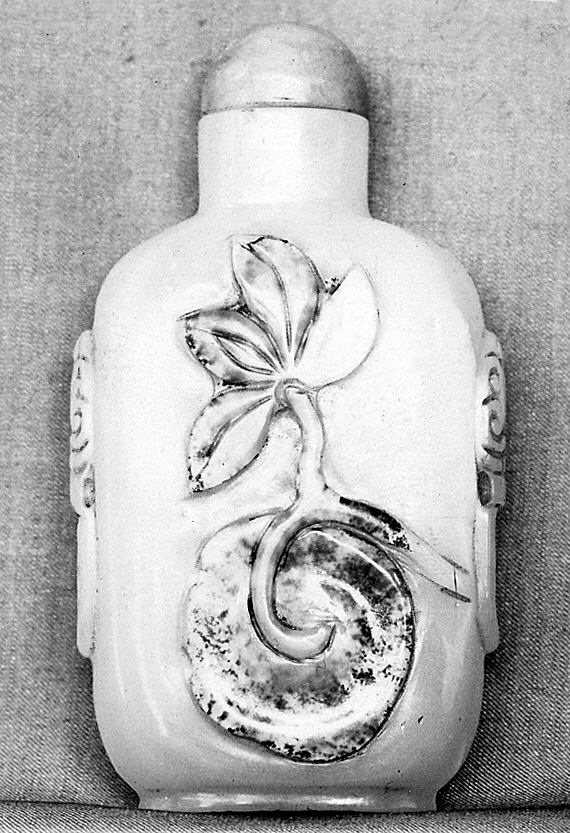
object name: snuff bottle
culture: chinese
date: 1801-1900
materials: alabaster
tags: plants